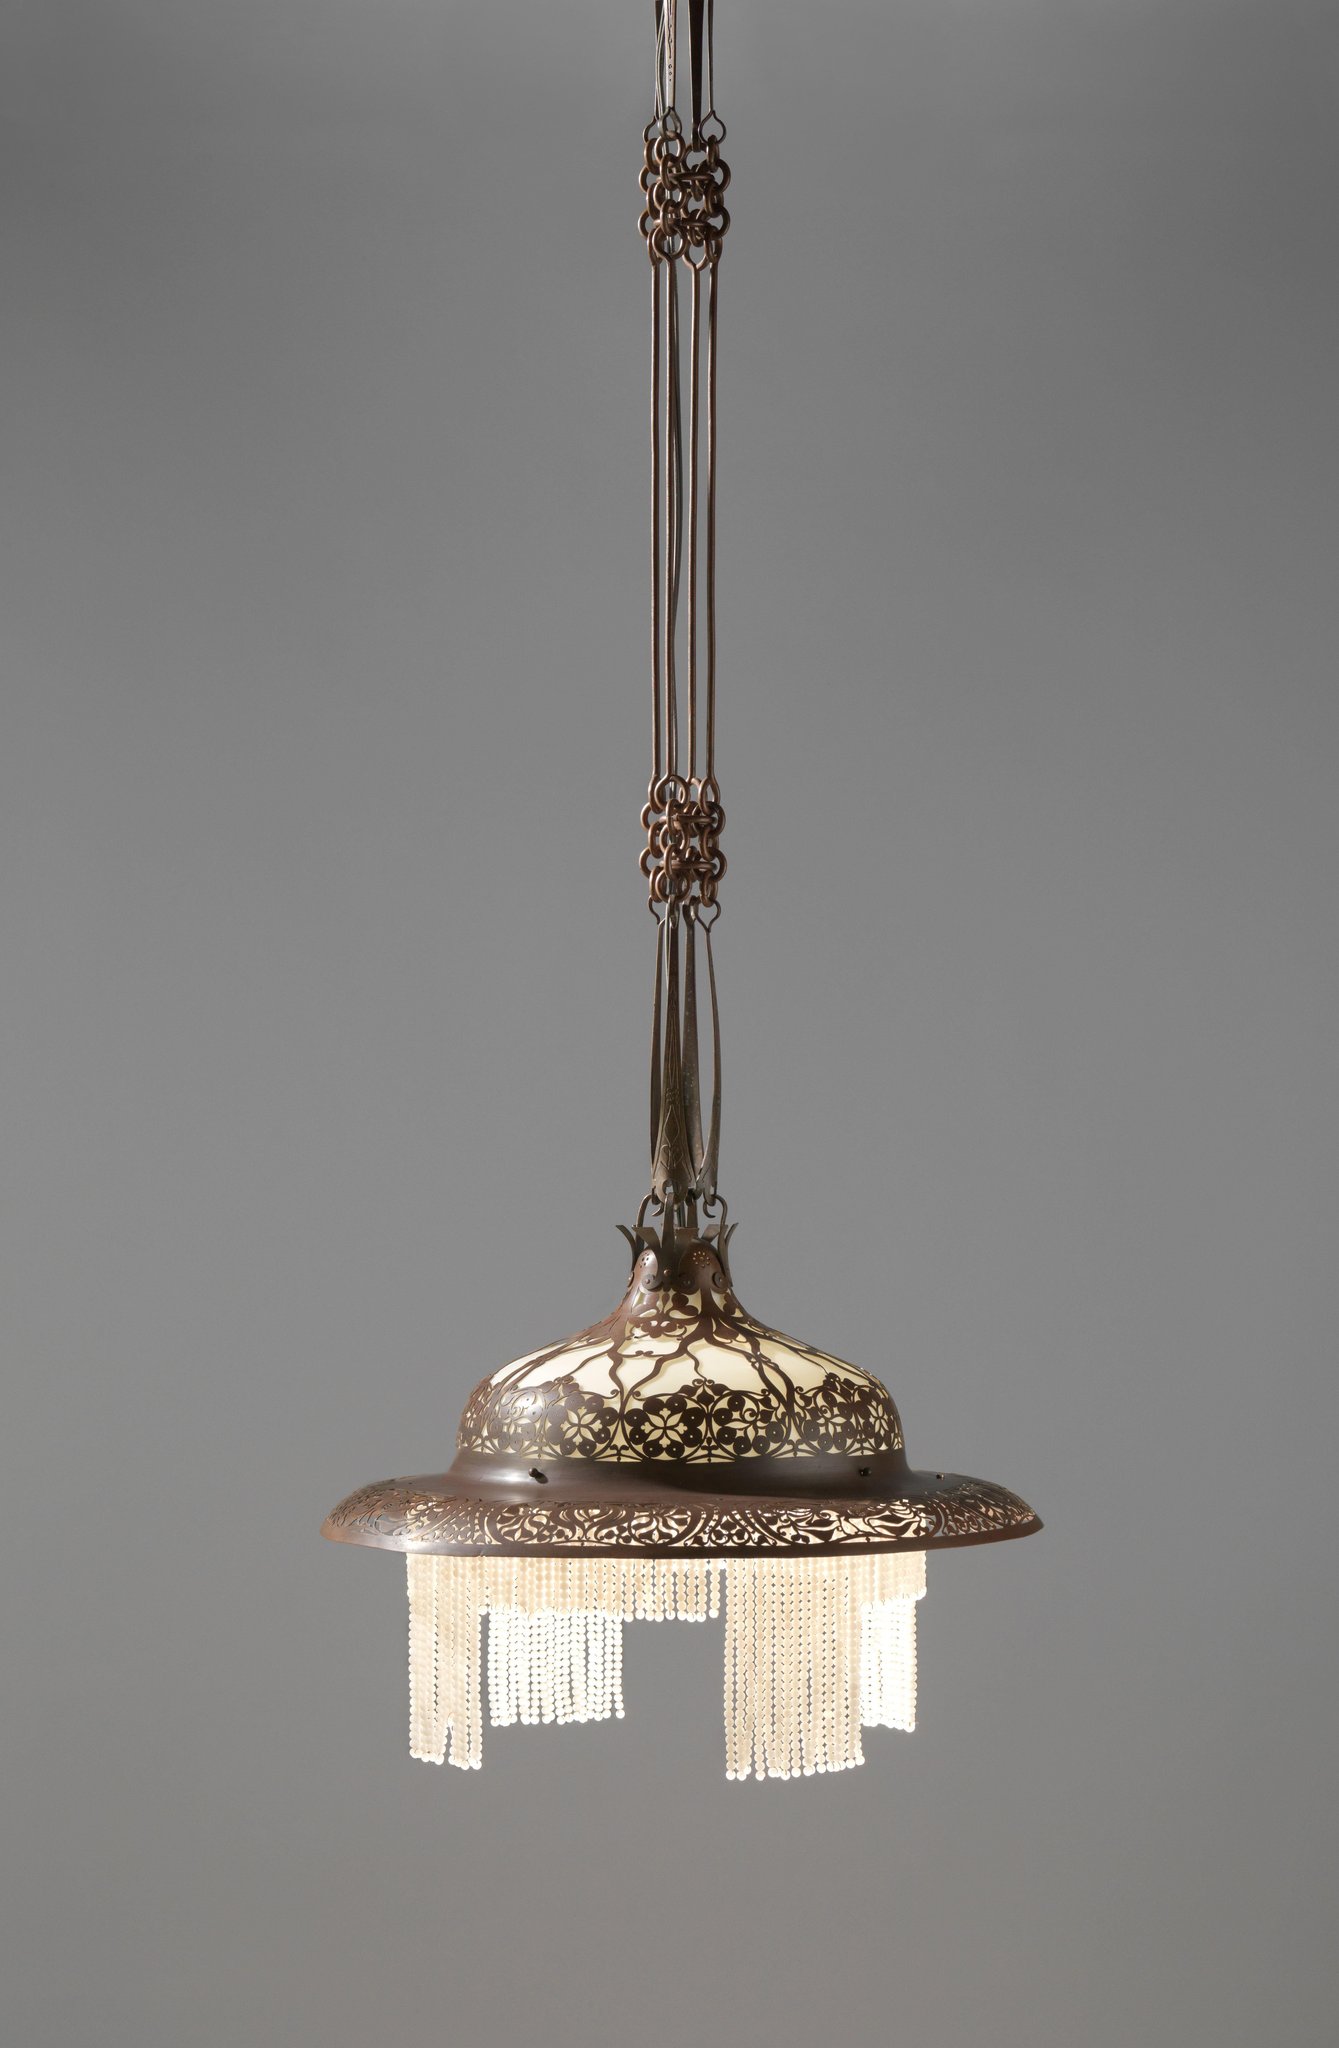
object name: hanging lamp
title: Ketting van een koperen hanglamp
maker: theo nieuwenhuis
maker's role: designer, draughtsman, print maker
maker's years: 1866-1951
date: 1916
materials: copper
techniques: etching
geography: amsterdam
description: Elektrische hanglamp van rood koper bestaande uit een aan vier kettingen gehangen kap die is opengewerkt met ranken en vogelmotieven. Aan de binnenzijde is een bol van matglas. De kettingen bestaan uit drie stangen die op twee plekken onderbroken zijn door schakels. De kap is aan de onderzijde afgezet met een volant van matglazen kralen en afgeschermd met een naturelkleurige gebatikte doek.